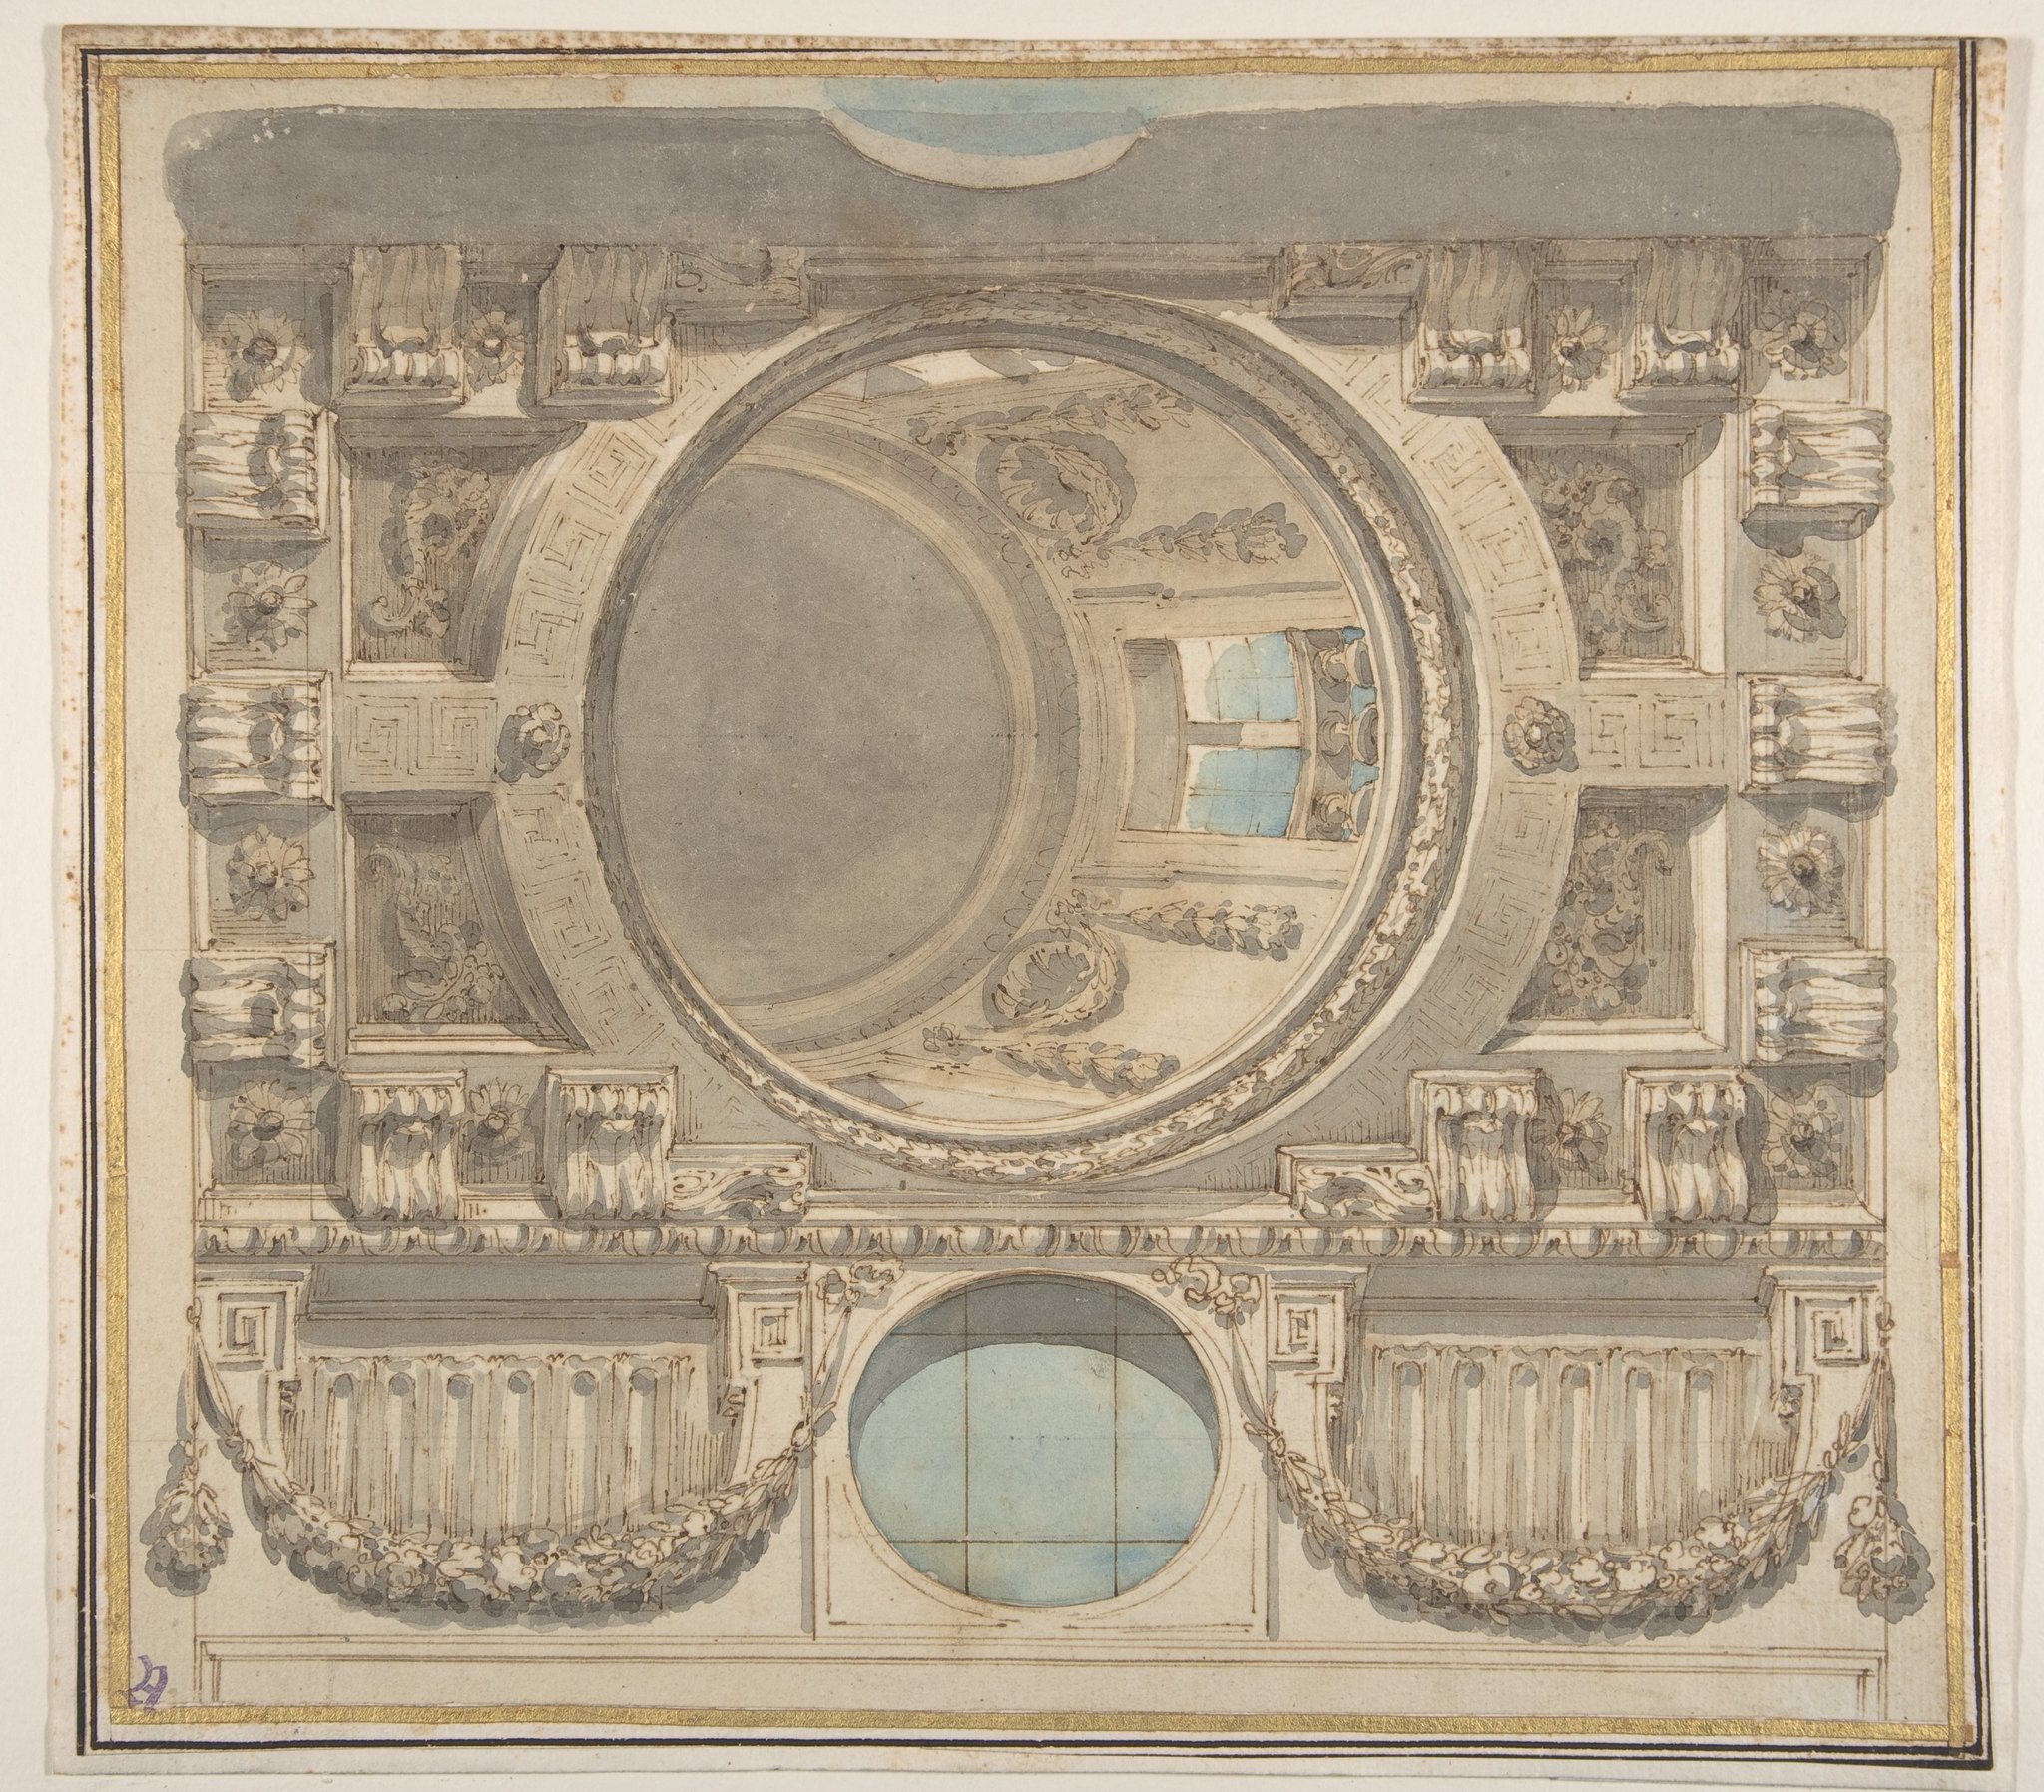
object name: drawing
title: Architectural Design for a Ceiling with a Dome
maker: flaminio innocenzo minozzi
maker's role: artist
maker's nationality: italian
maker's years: 1735-1817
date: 1755-1817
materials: ink, drawing material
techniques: brush, pen, wash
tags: architecture,domes